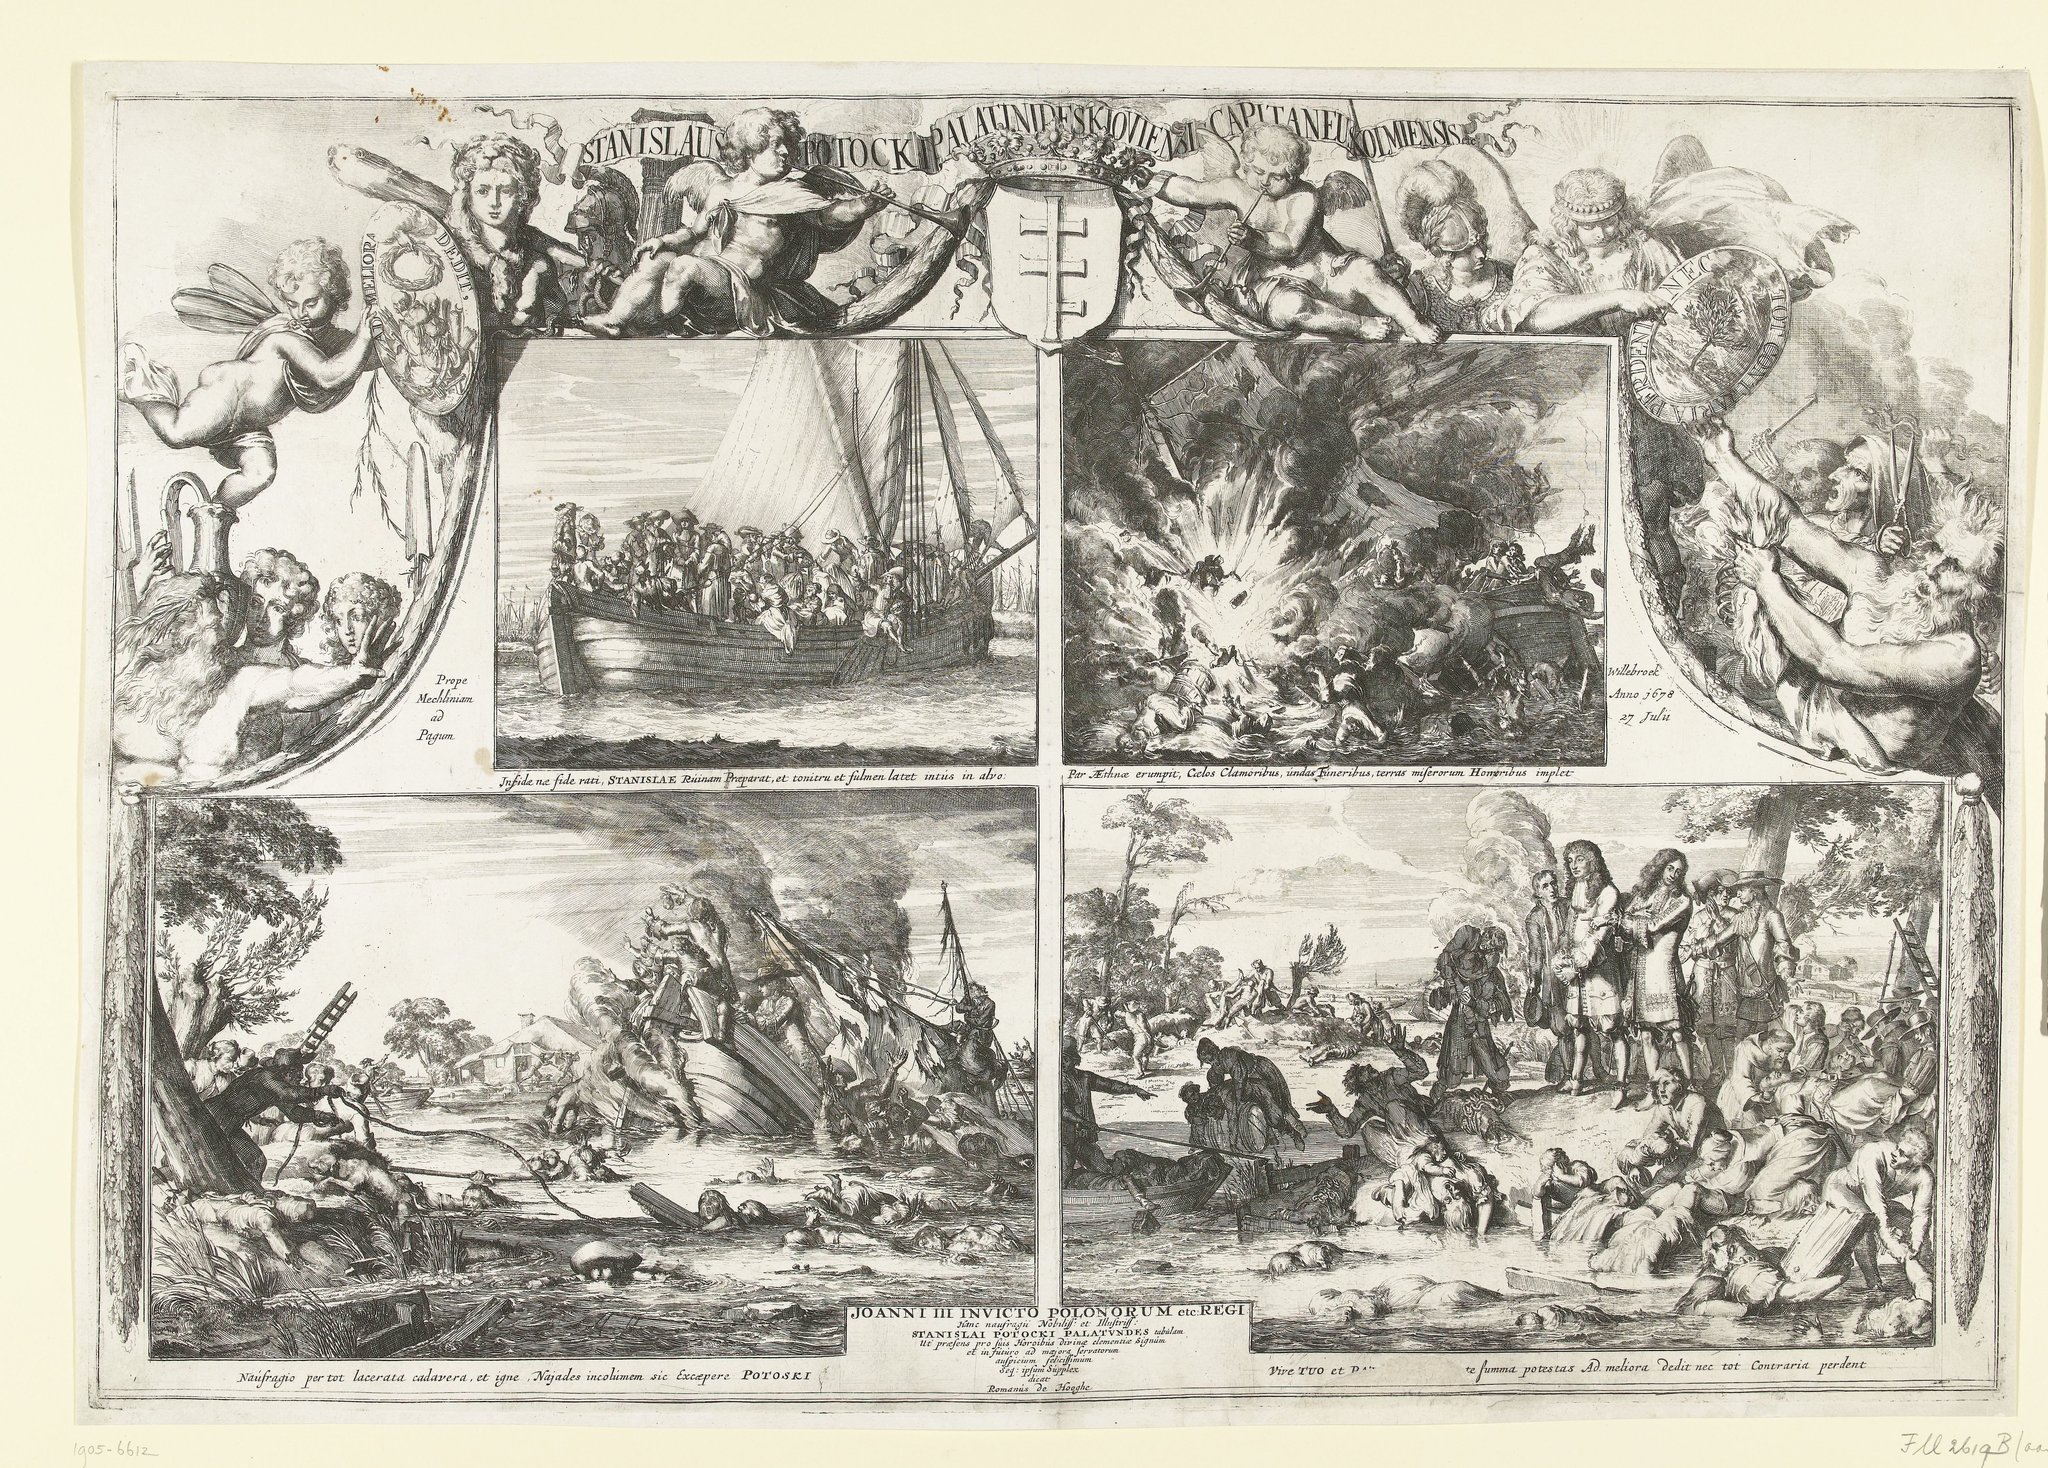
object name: print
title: Het ongeluk van graaf Stanislaw Potocki, 1678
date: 1678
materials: paper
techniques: engraving, etching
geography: northern netherlands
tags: jan iii sobieski (koning van polen), shipwreck, mechelen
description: Monument met vier scènes van het ongeluk dat de graaf Stanislaw Potocki treft op 27 juli 1678. Linksboven zeilt het schip met haar passagiers uit Mechelen, rechts ontploft het schip nabij Willebroek, linksonder probeert iedereen zich te redden, rechts de ongeschonden graaf staande te midden van gewonden en doden. Achter het monument allegorische figuren, bovenaan het wapen van Potocki. Onder de scènes opschriften in het Latijn.